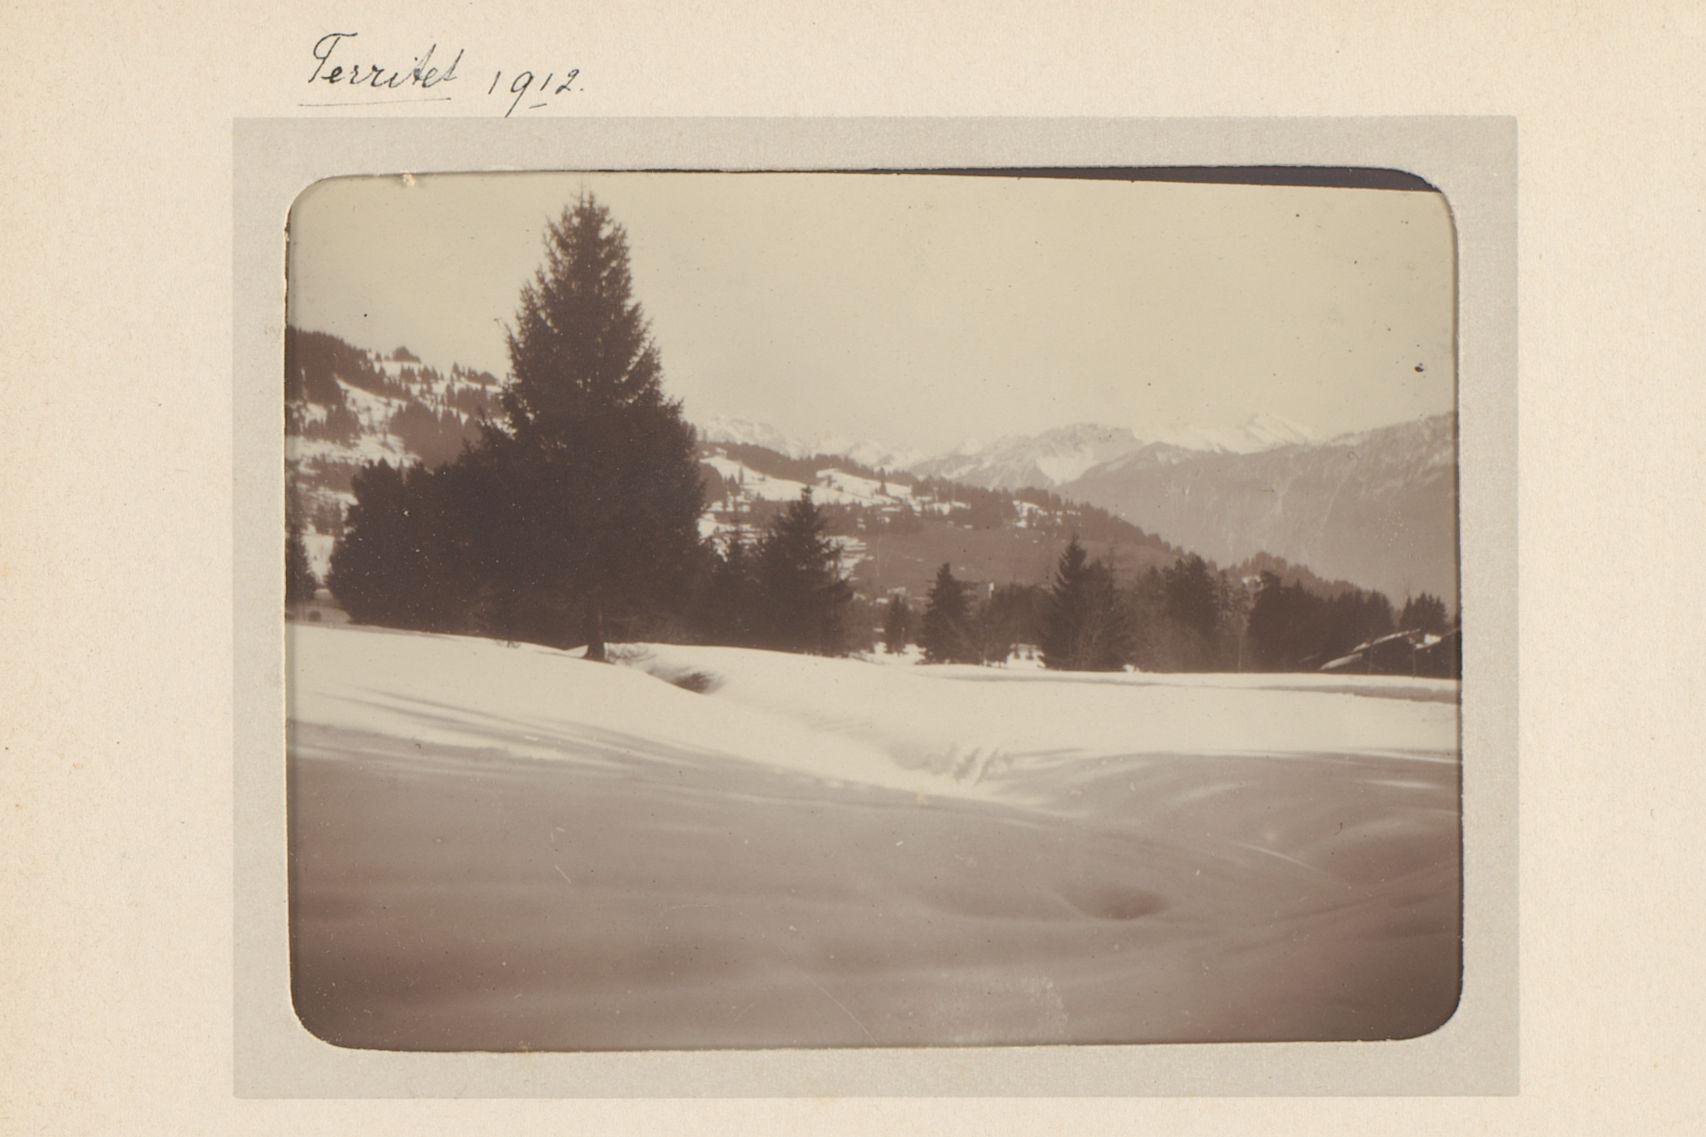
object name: album leaf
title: Sneeuwlandschap in de bergen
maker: liesbeth overhoff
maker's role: fotograaf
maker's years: 1895-1969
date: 1911-1915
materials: paper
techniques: gelatin silver print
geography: territet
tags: dale, valley, snow, mountains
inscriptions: inscription: ‘Territet 1912’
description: Dit bevroren bergmeer is ook afgebeeld op RP-F-F01201-10-3.